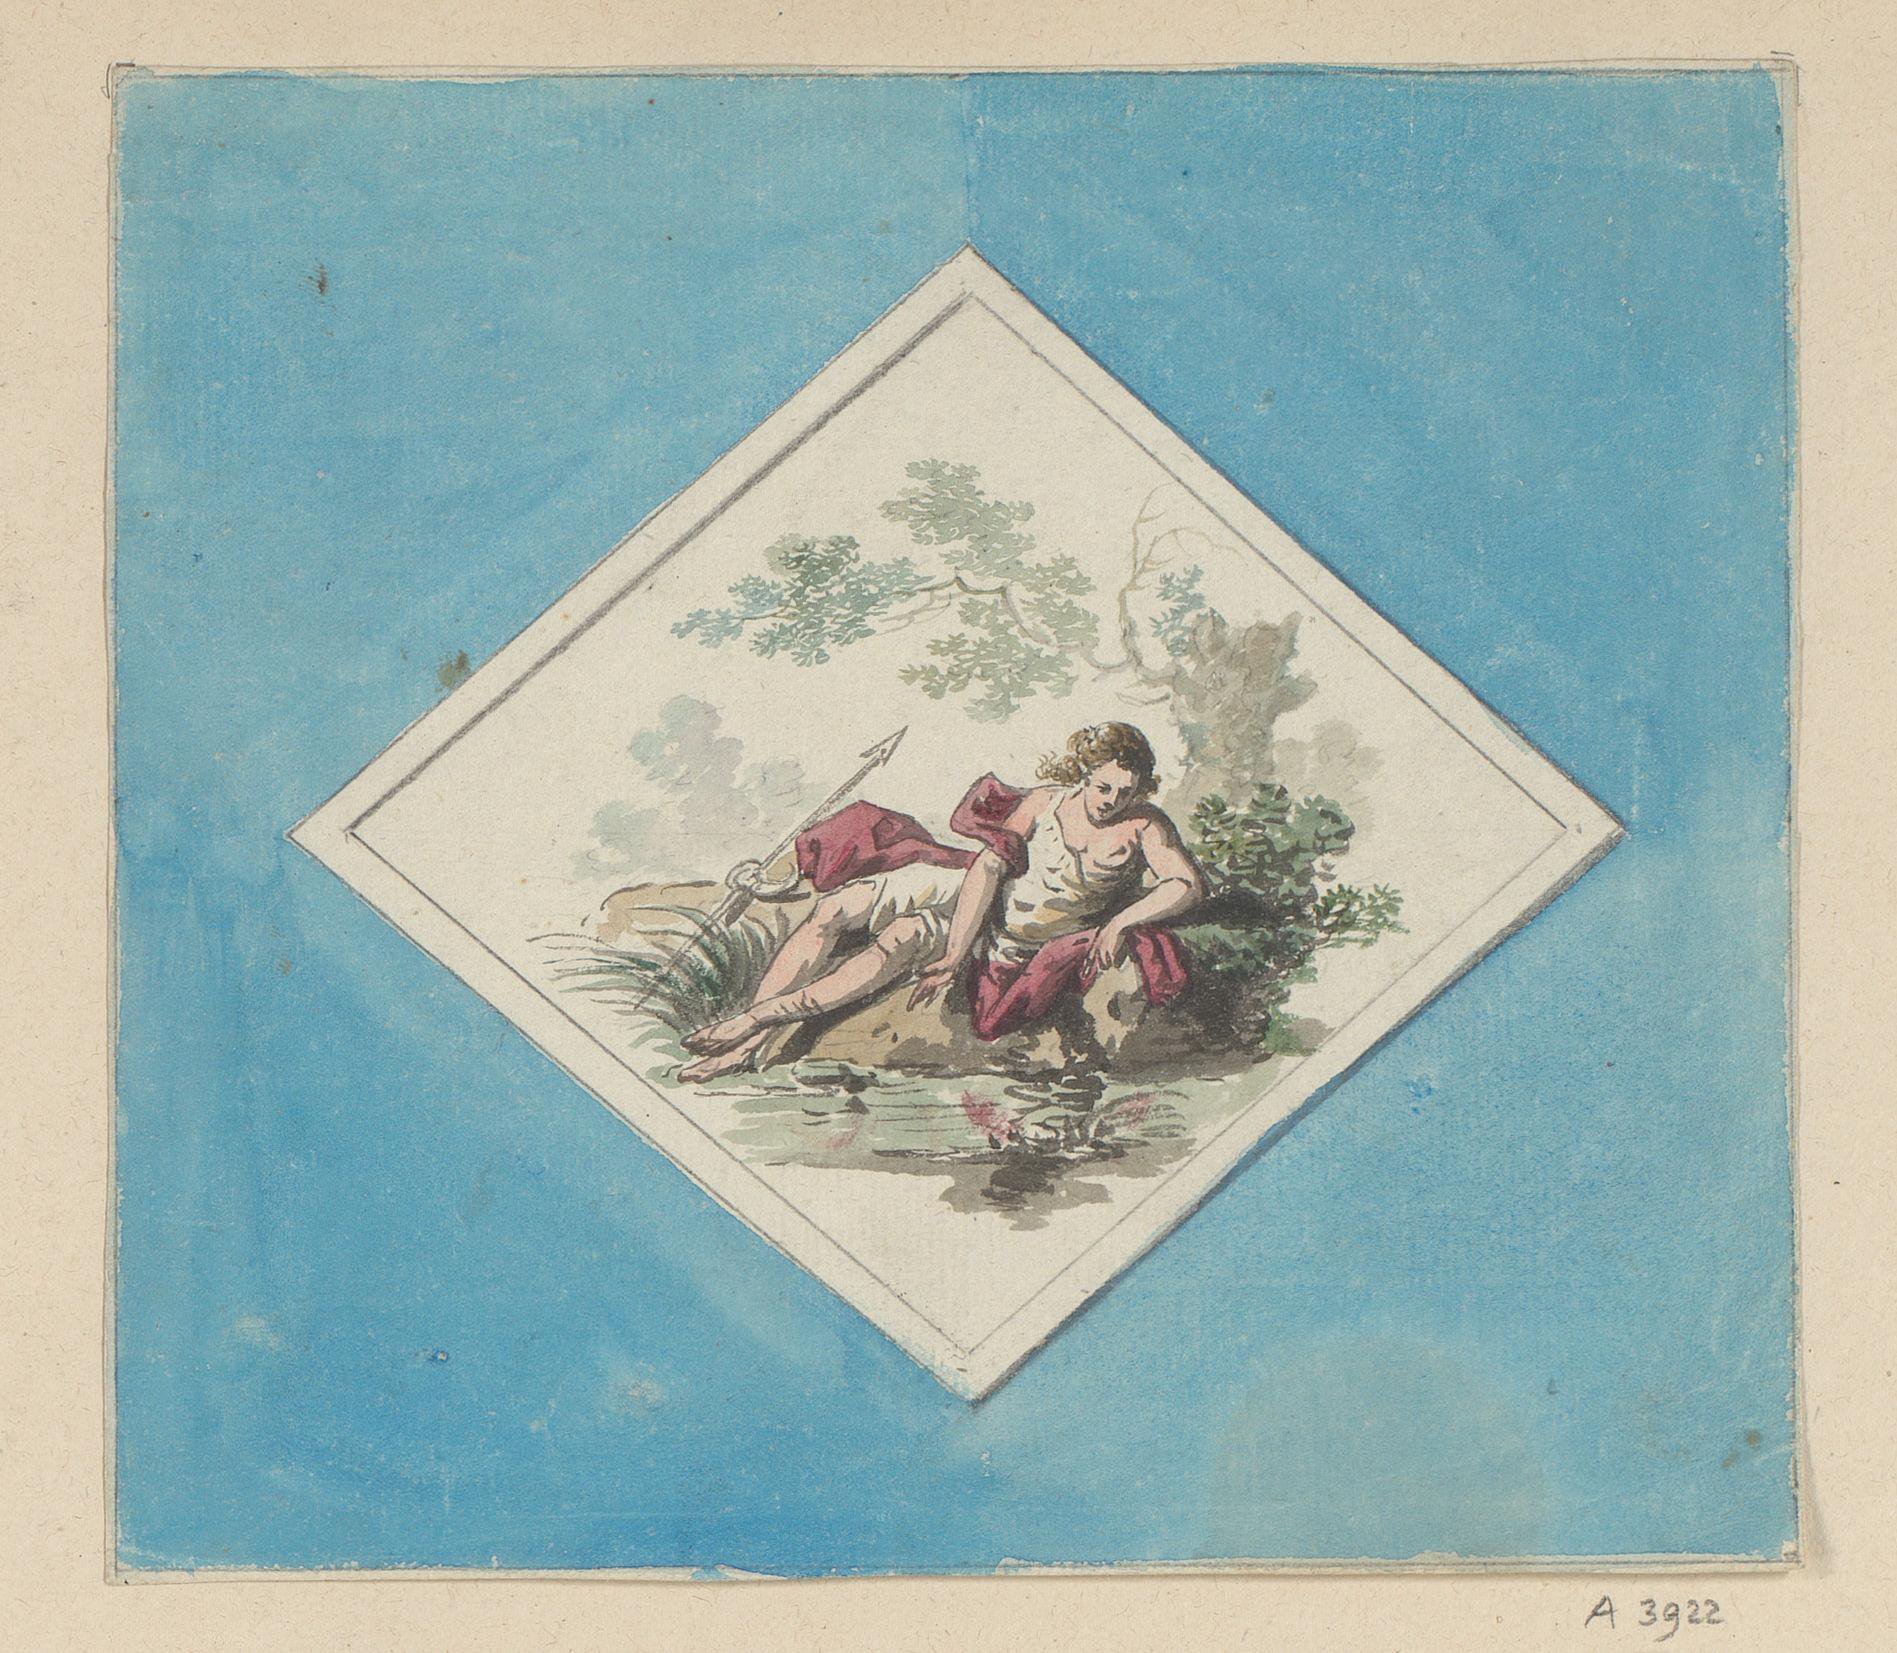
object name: album leaf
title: Narcissus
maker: abraham van strij (i)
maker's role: draughtsman, painter, print maker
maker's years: 1753-1826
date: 1763-1826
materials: paint, paper, pencil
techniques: brush, pen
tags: (story of) narcissus, wall-covering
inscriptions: collector's mark: Lugt 2228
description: De tekeningen van Abraham van Strij zijn op een later moment ingevoegd in het album met tekeningen van Jurriaan Andriessen.